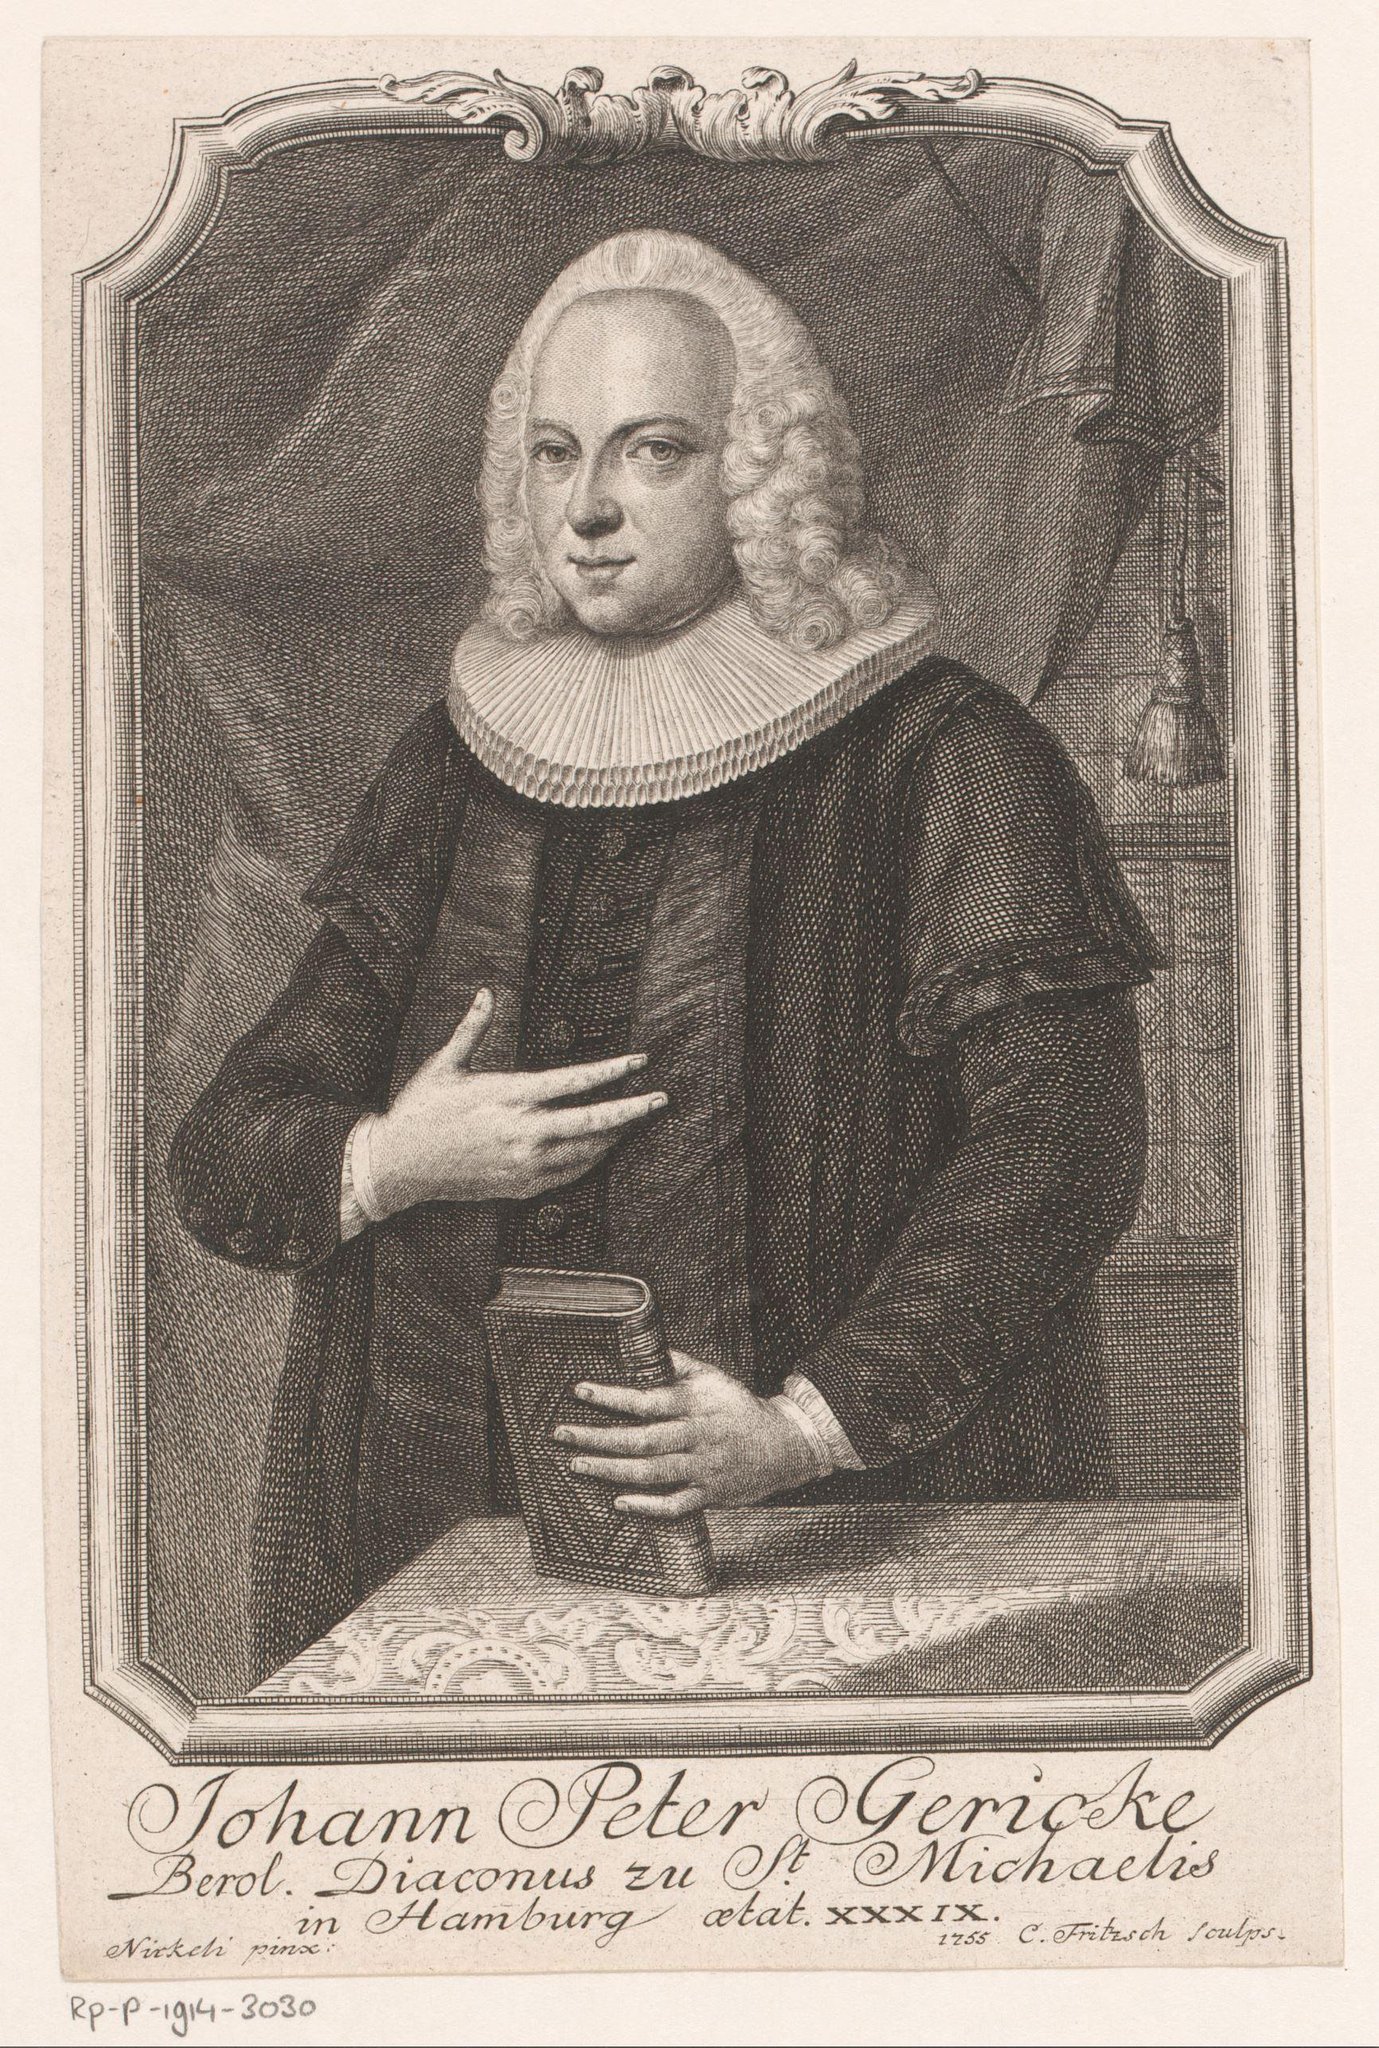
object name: print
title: Portret van Johann Peter Gericke op 39-jarige leeftijd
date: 1755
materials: paper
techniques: engraving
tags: berlin, historical persons, book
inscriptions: collector's mark: Lugt 2228